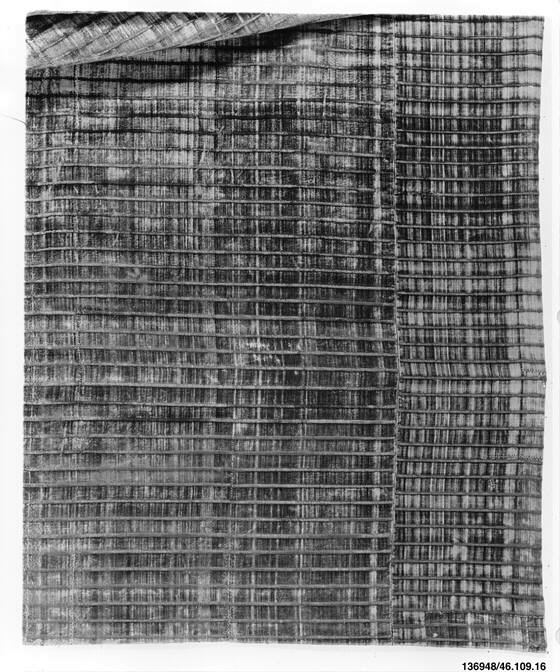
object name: velvet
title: Red Silk Velvet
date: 1567-1600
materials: silk